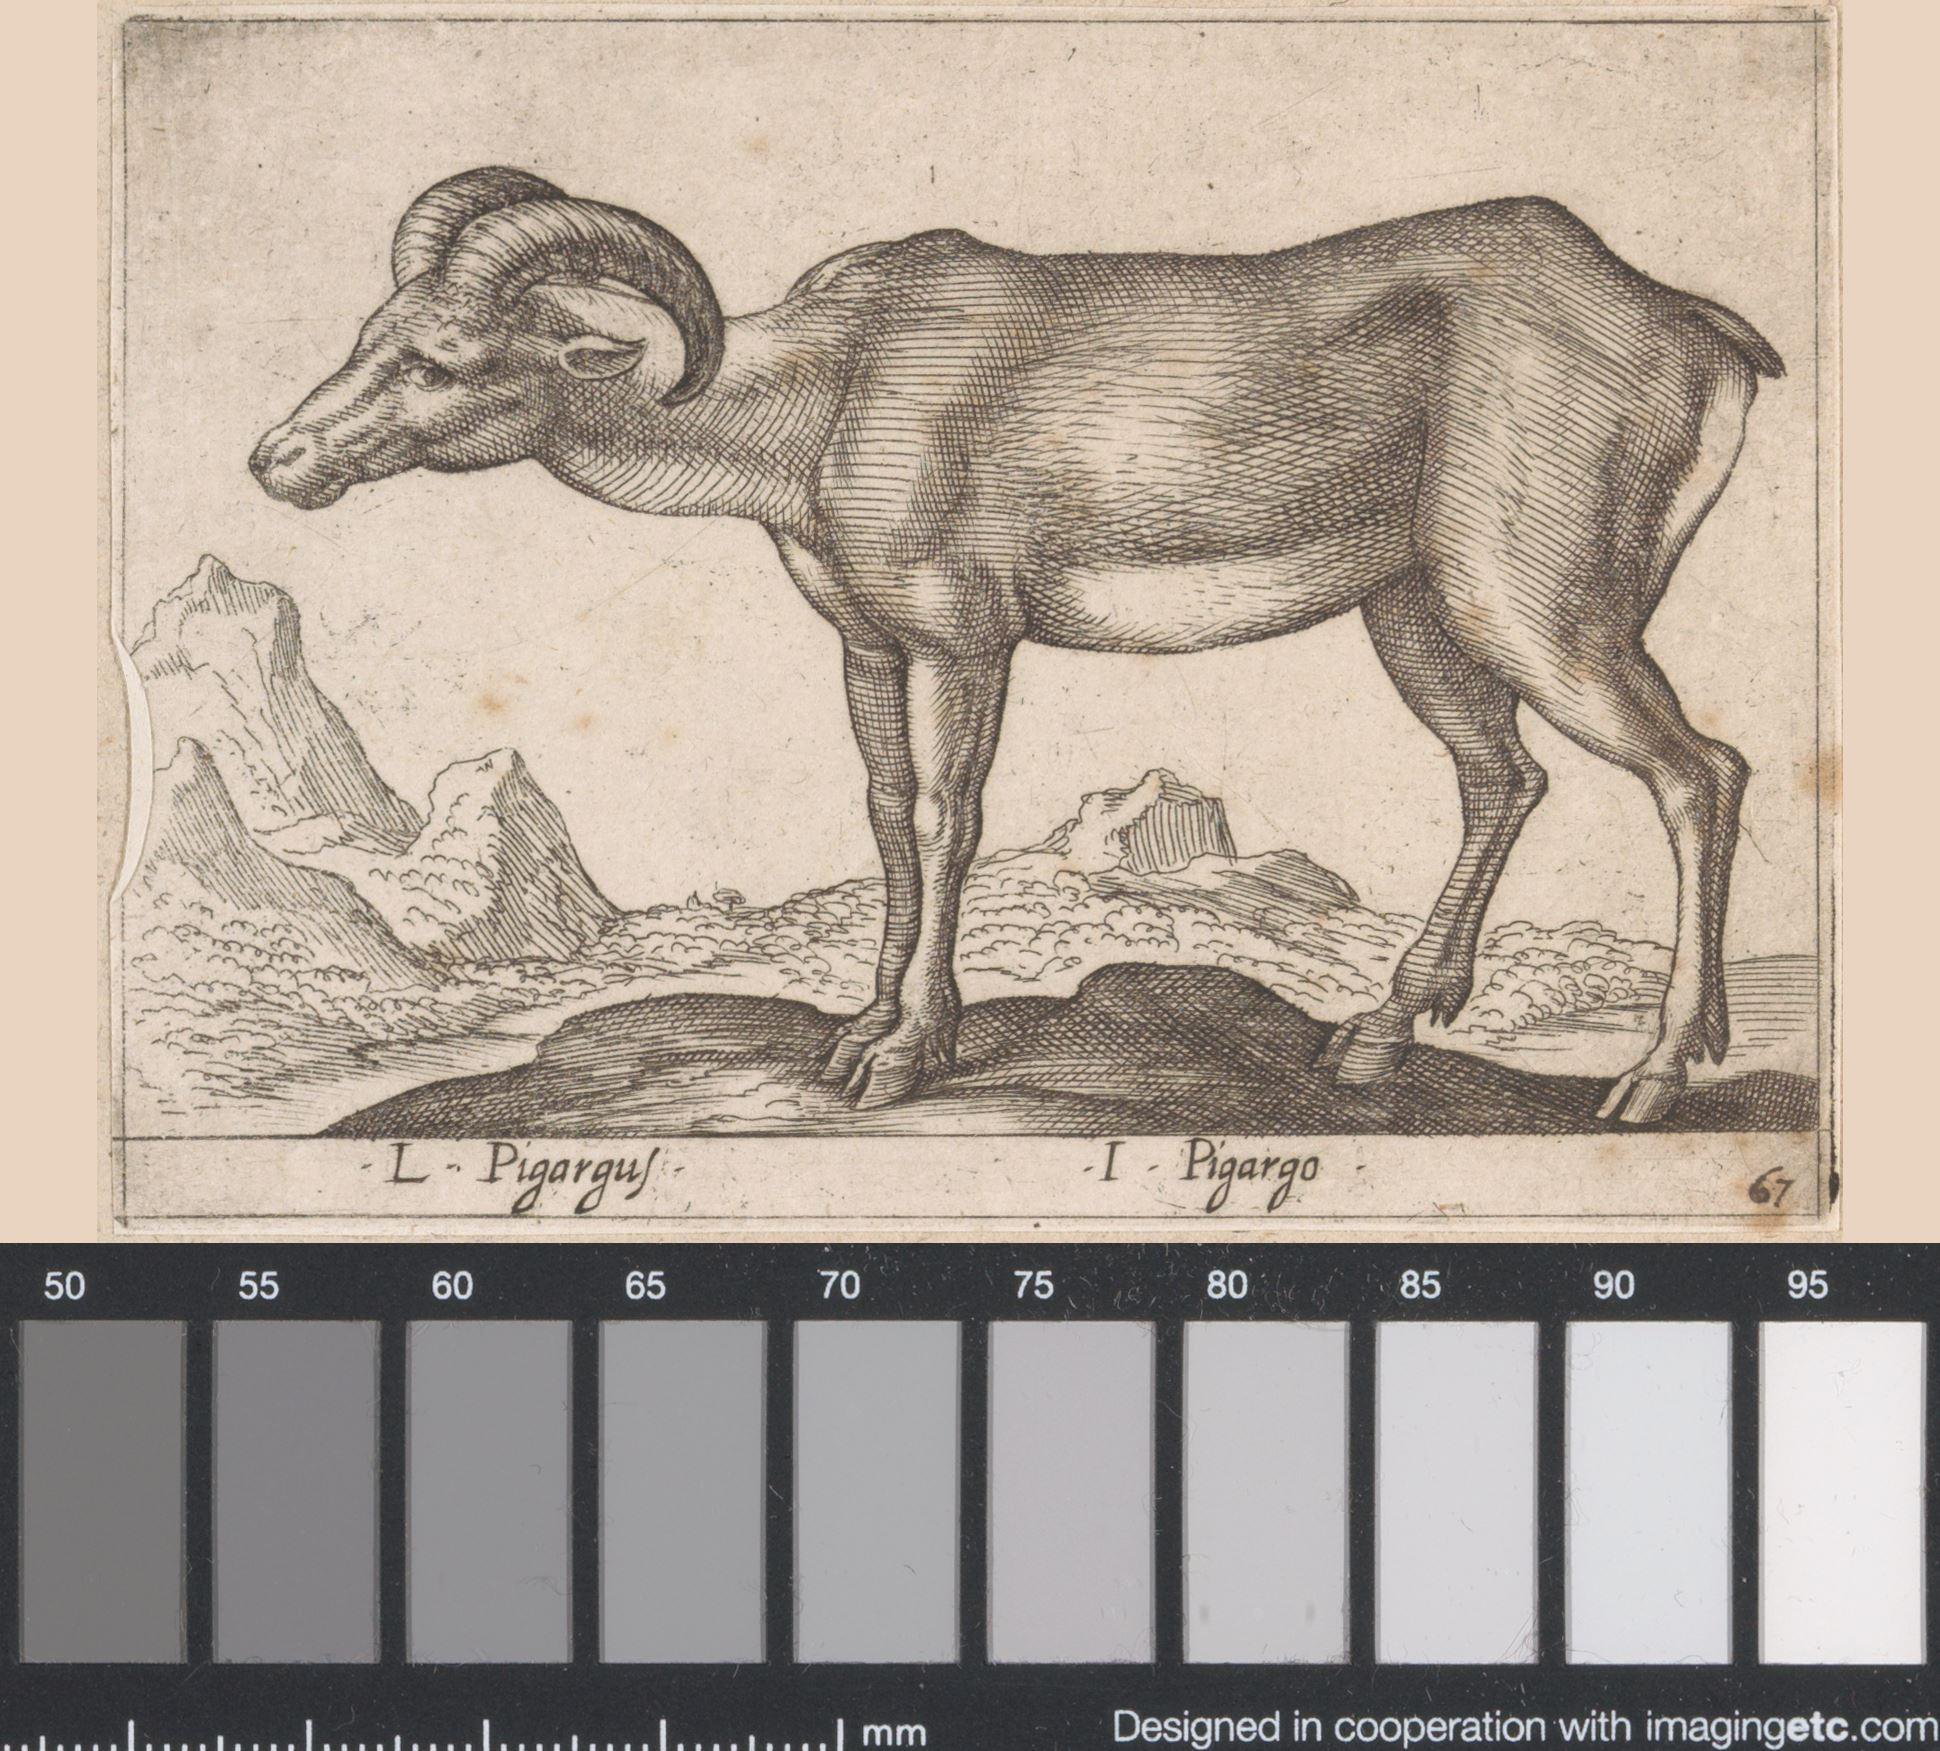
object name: print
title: L Pigargus/ I Pigargo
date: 1565-1630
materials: paper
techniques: etching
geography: italy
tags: goat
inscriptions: number: ‘67’, collector's mark: Lugt 11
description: Deze prent maakt deel uit van een reeks prenten van dieren door Antonio Tempesta. Bekend is dat een tweede staat (met nummering) van deze serie is uitgegeven door Giovanni Giacomo de' Rossi in 1650. Onbekend is wie de eerste staat heeft uitgegeven en wanneer.